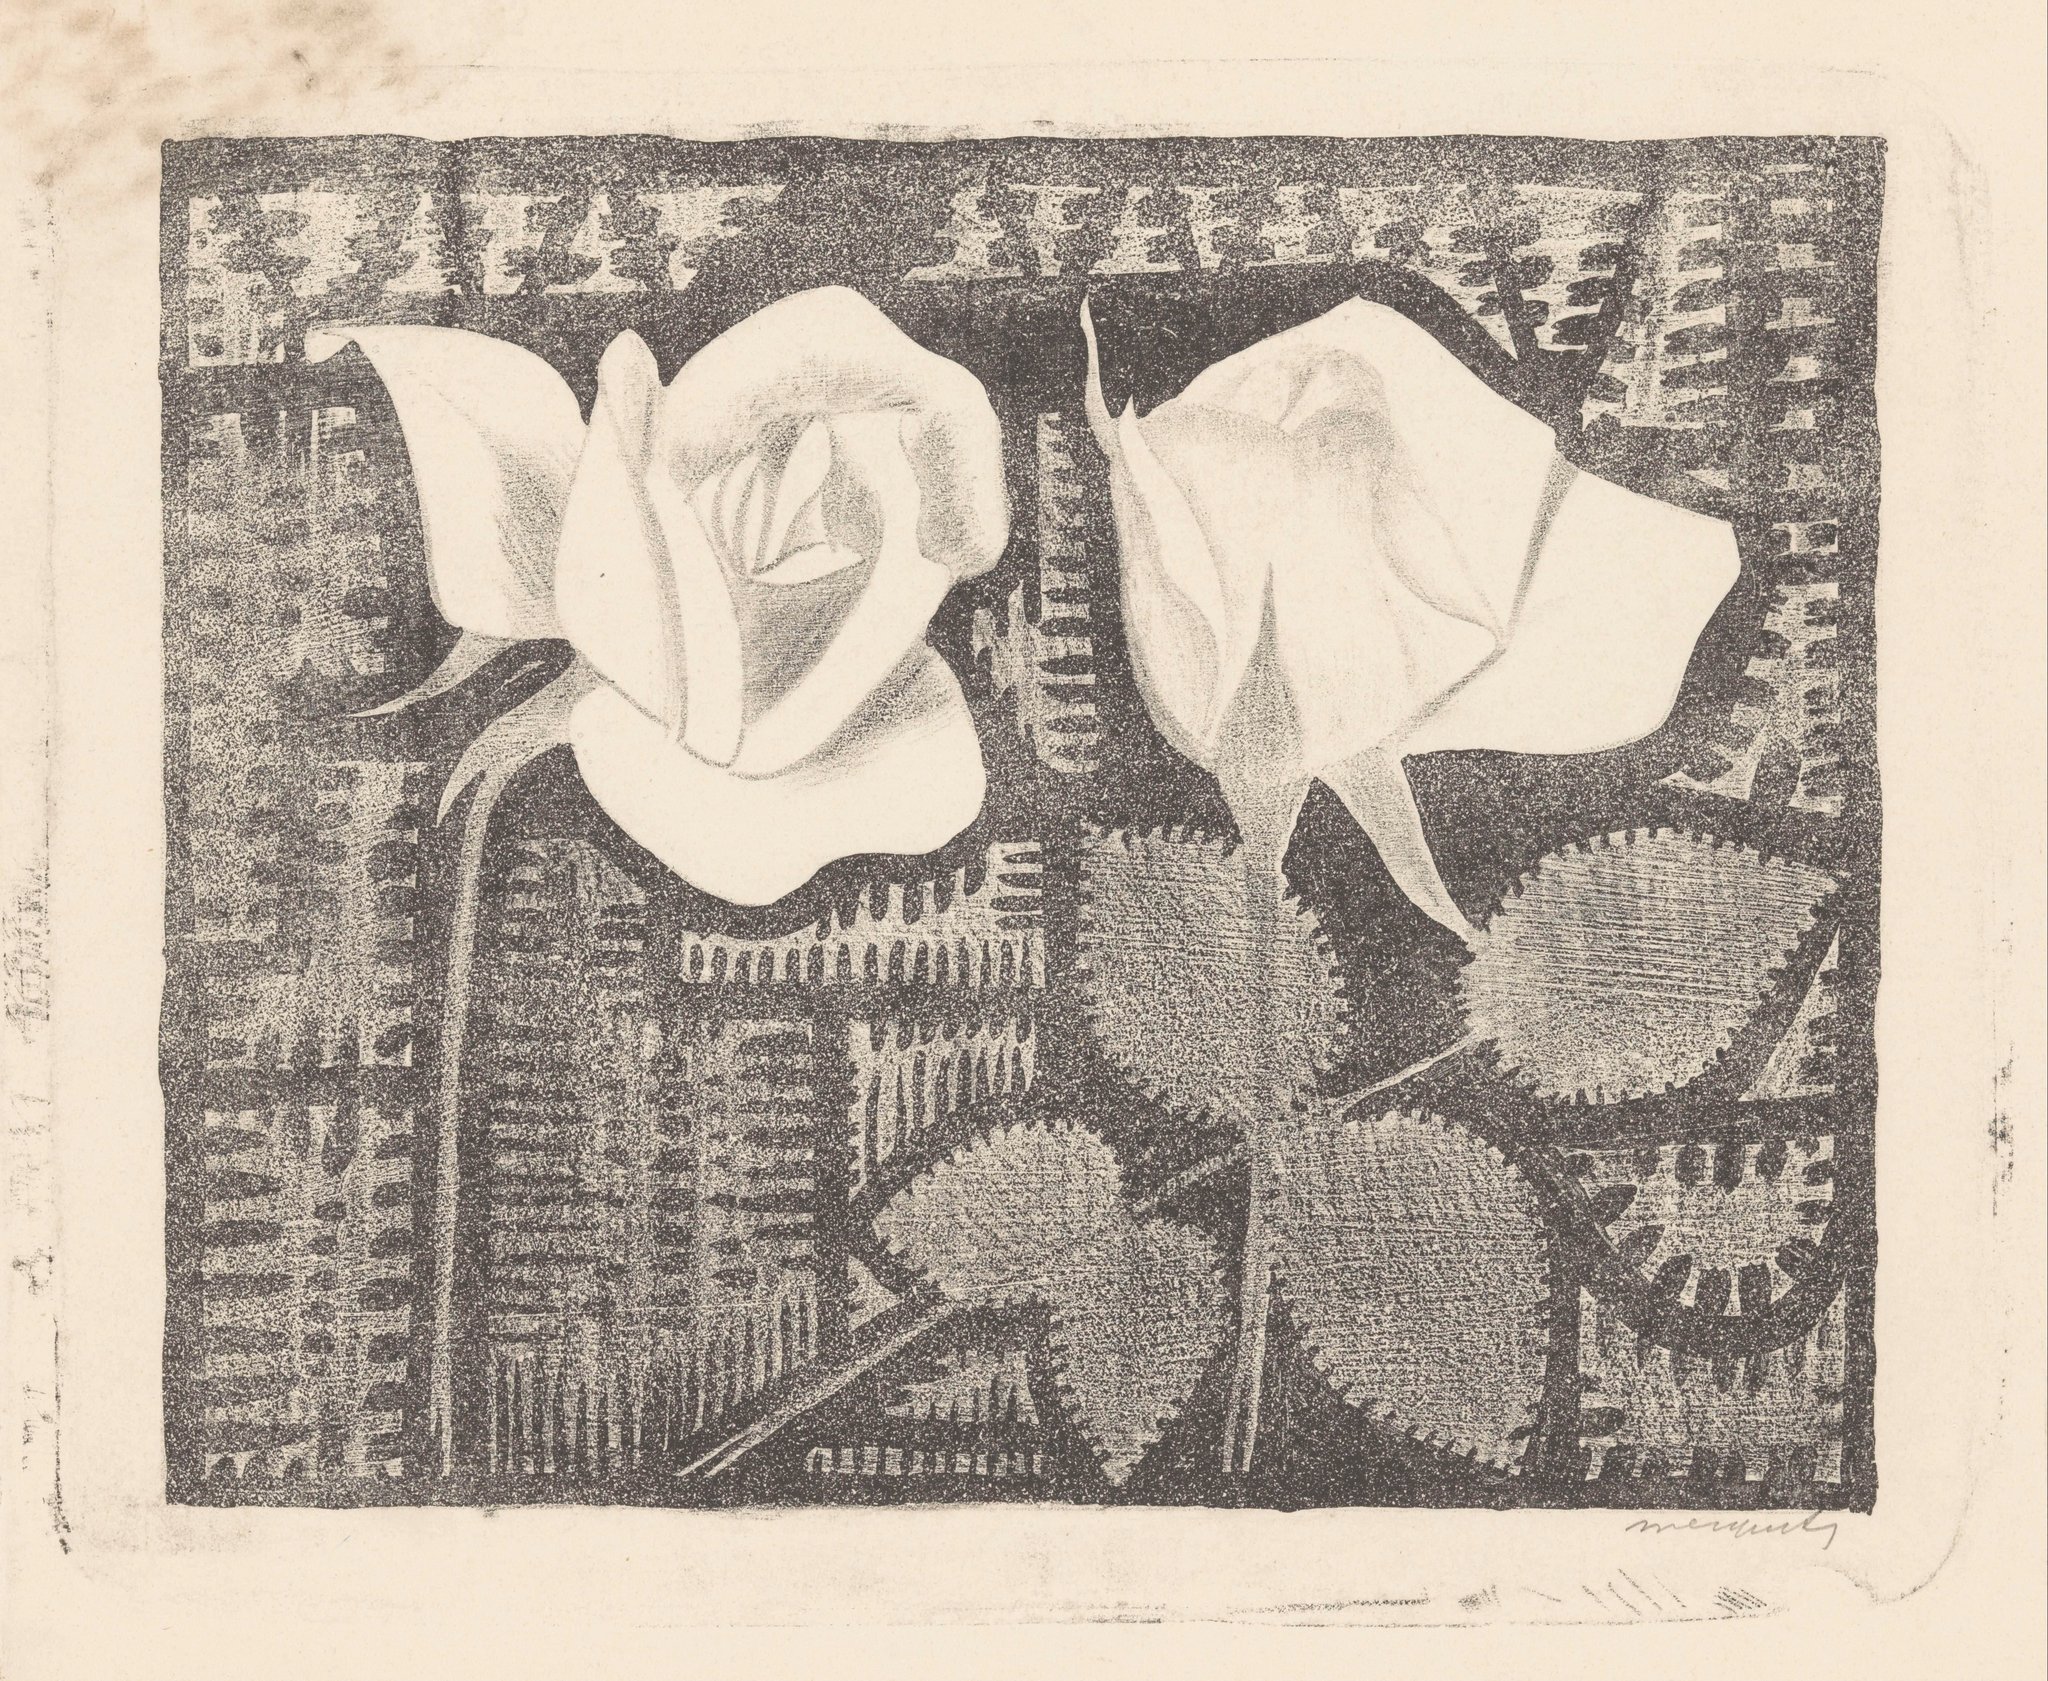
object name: print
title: Twee rozen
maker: samuel jessurun de mesquita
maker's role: draughtsman, print maker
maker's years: 1868-1944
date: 1920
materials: paper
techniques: lithograph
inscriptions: signature: ‘mesquita’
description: Twee witte rozen en gebladerde tak tegen donkere achtergrond.